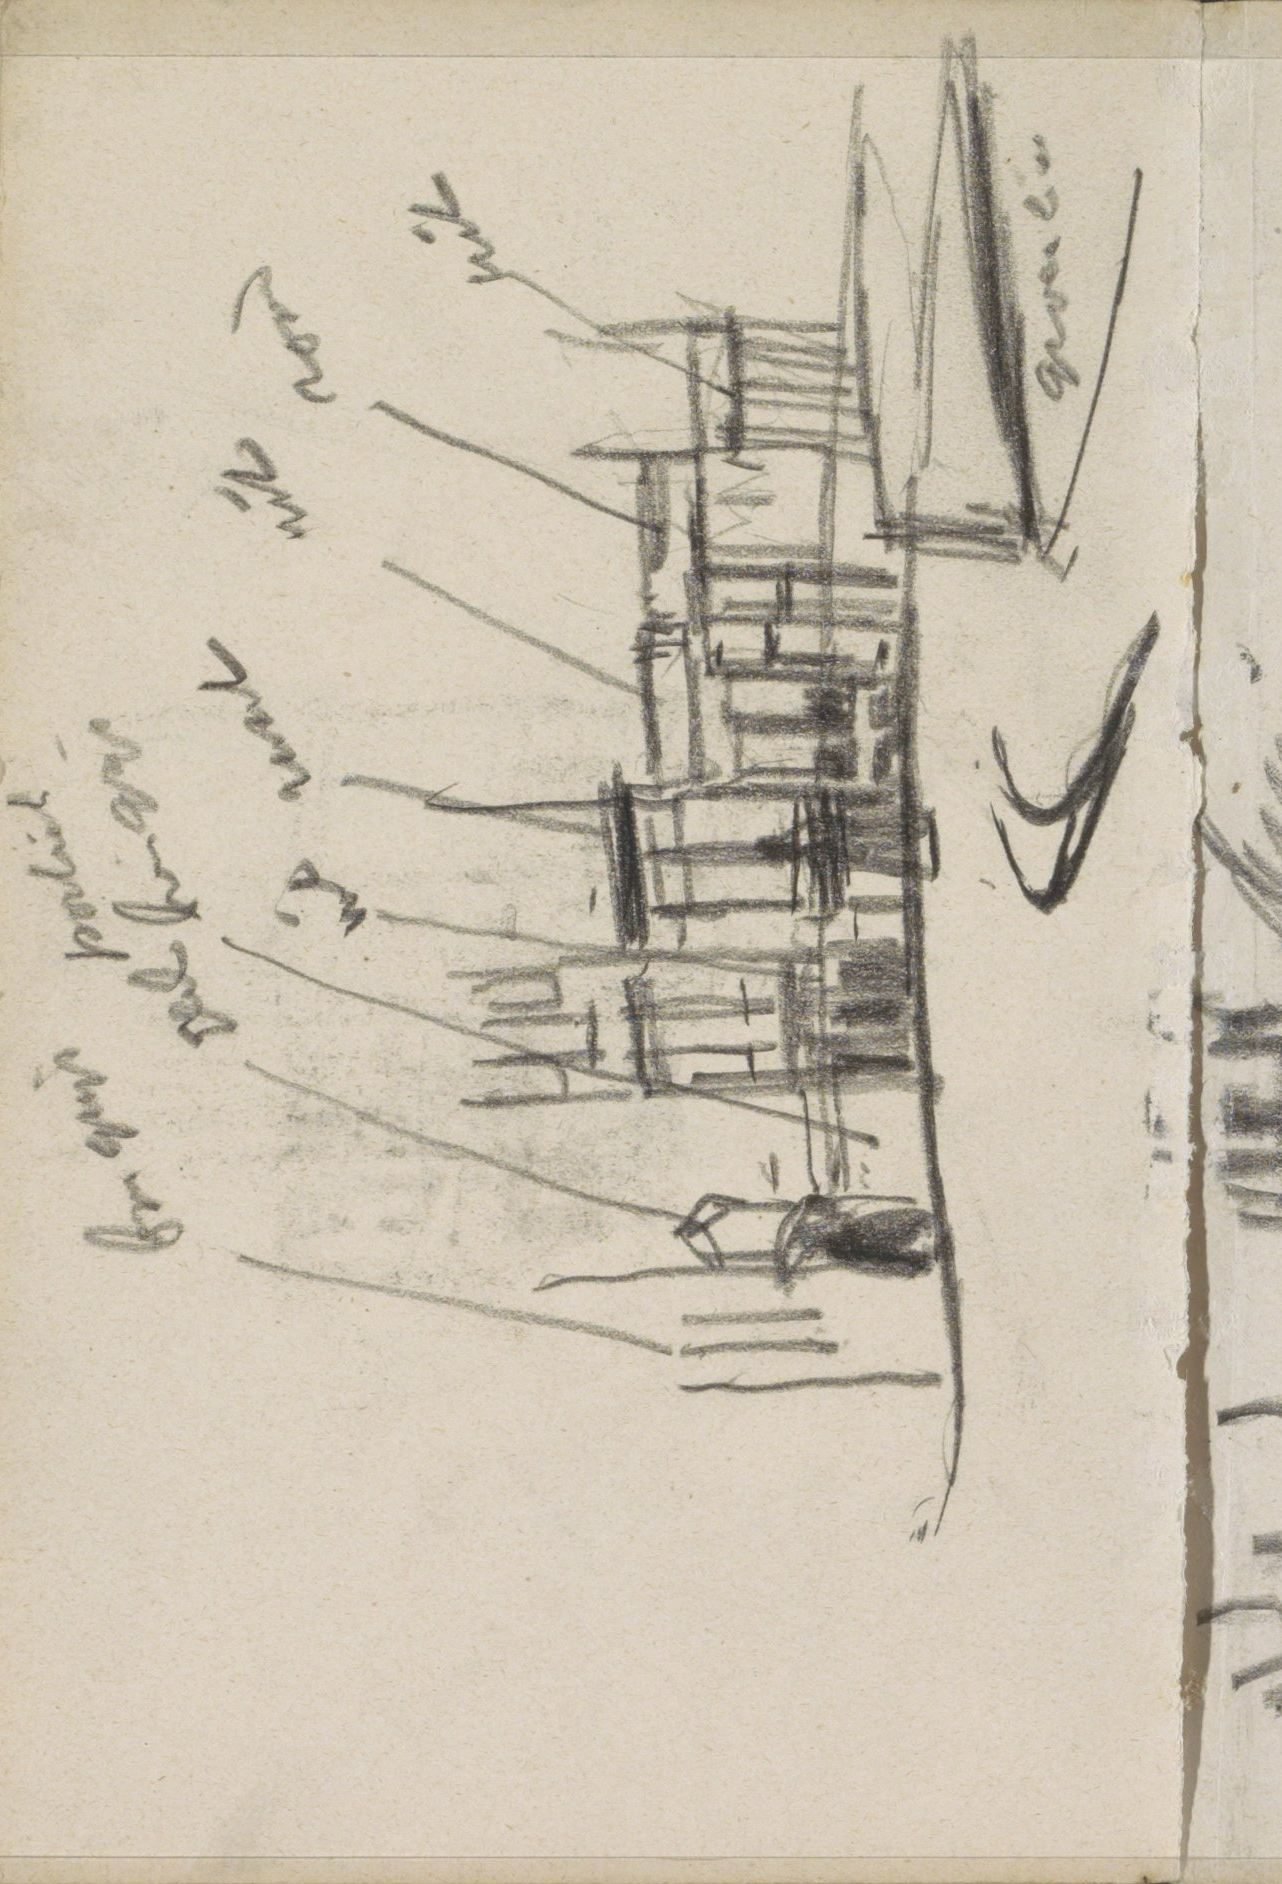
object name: sketchbook leaf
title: Gebouwen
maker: george hendrik breitner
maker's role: draughtsman, painter, print maker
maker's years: 1857-1923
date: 1912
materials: chalk, paper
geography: amsterdam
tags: city-view, and landscape with man-made constructions, civic architecture; edifices; dwellings, amsterdam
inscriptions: kleurnotitie, handgeschreven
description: Pagina 21 uit een schetsboek met 16 bladen.